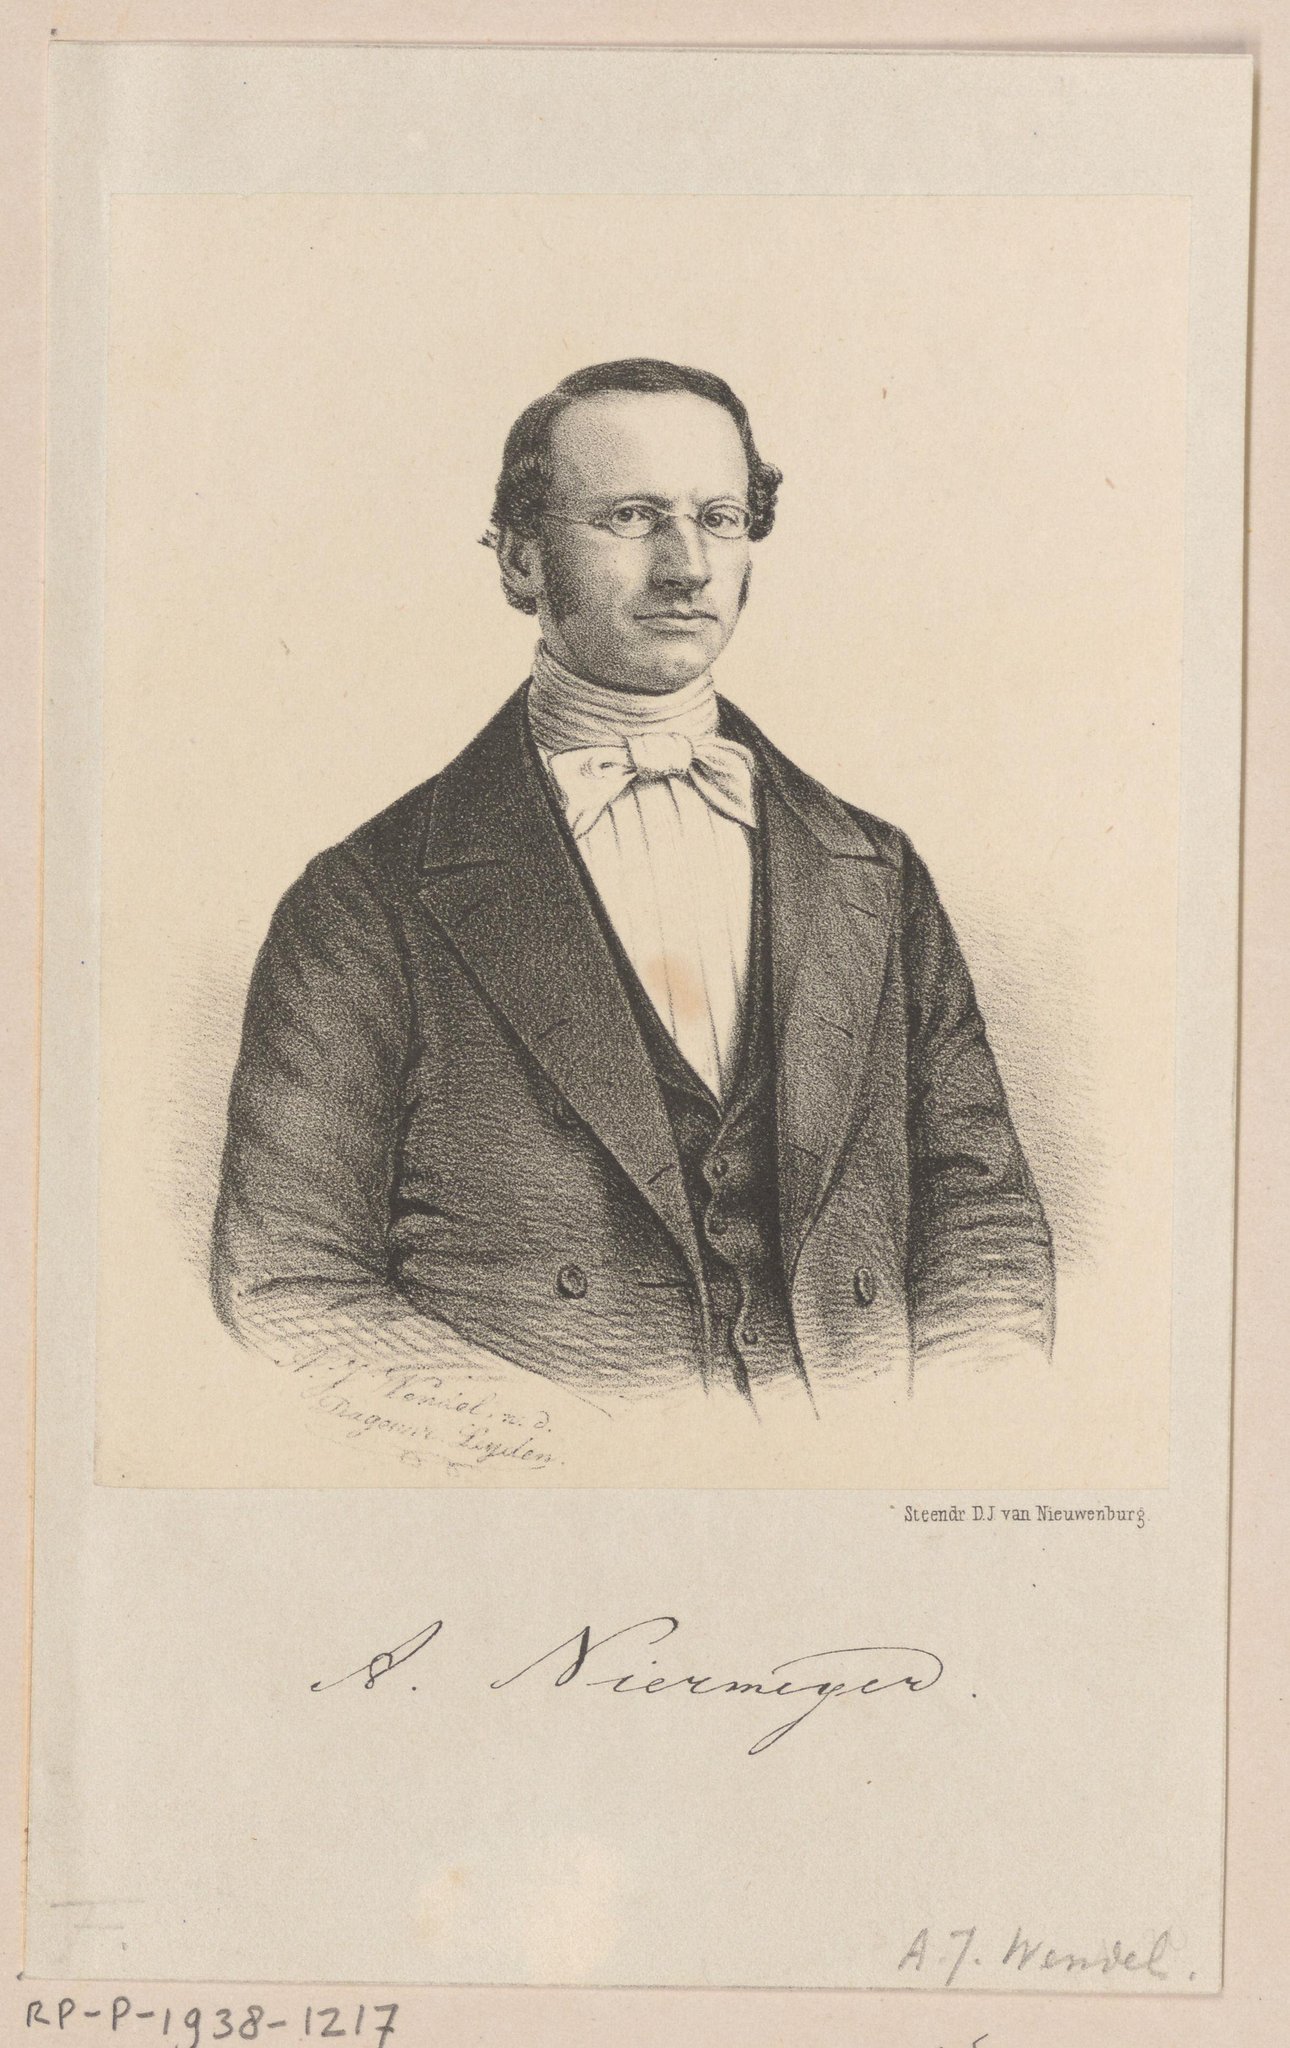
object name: print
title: Portret van Antonie Niermeijer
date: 1855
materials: paper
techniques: lithograph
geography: leiden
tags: leiden, historical persons, functionaries and dignitaries ~ protestant churches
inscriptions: collector's mark: Lugt 2228